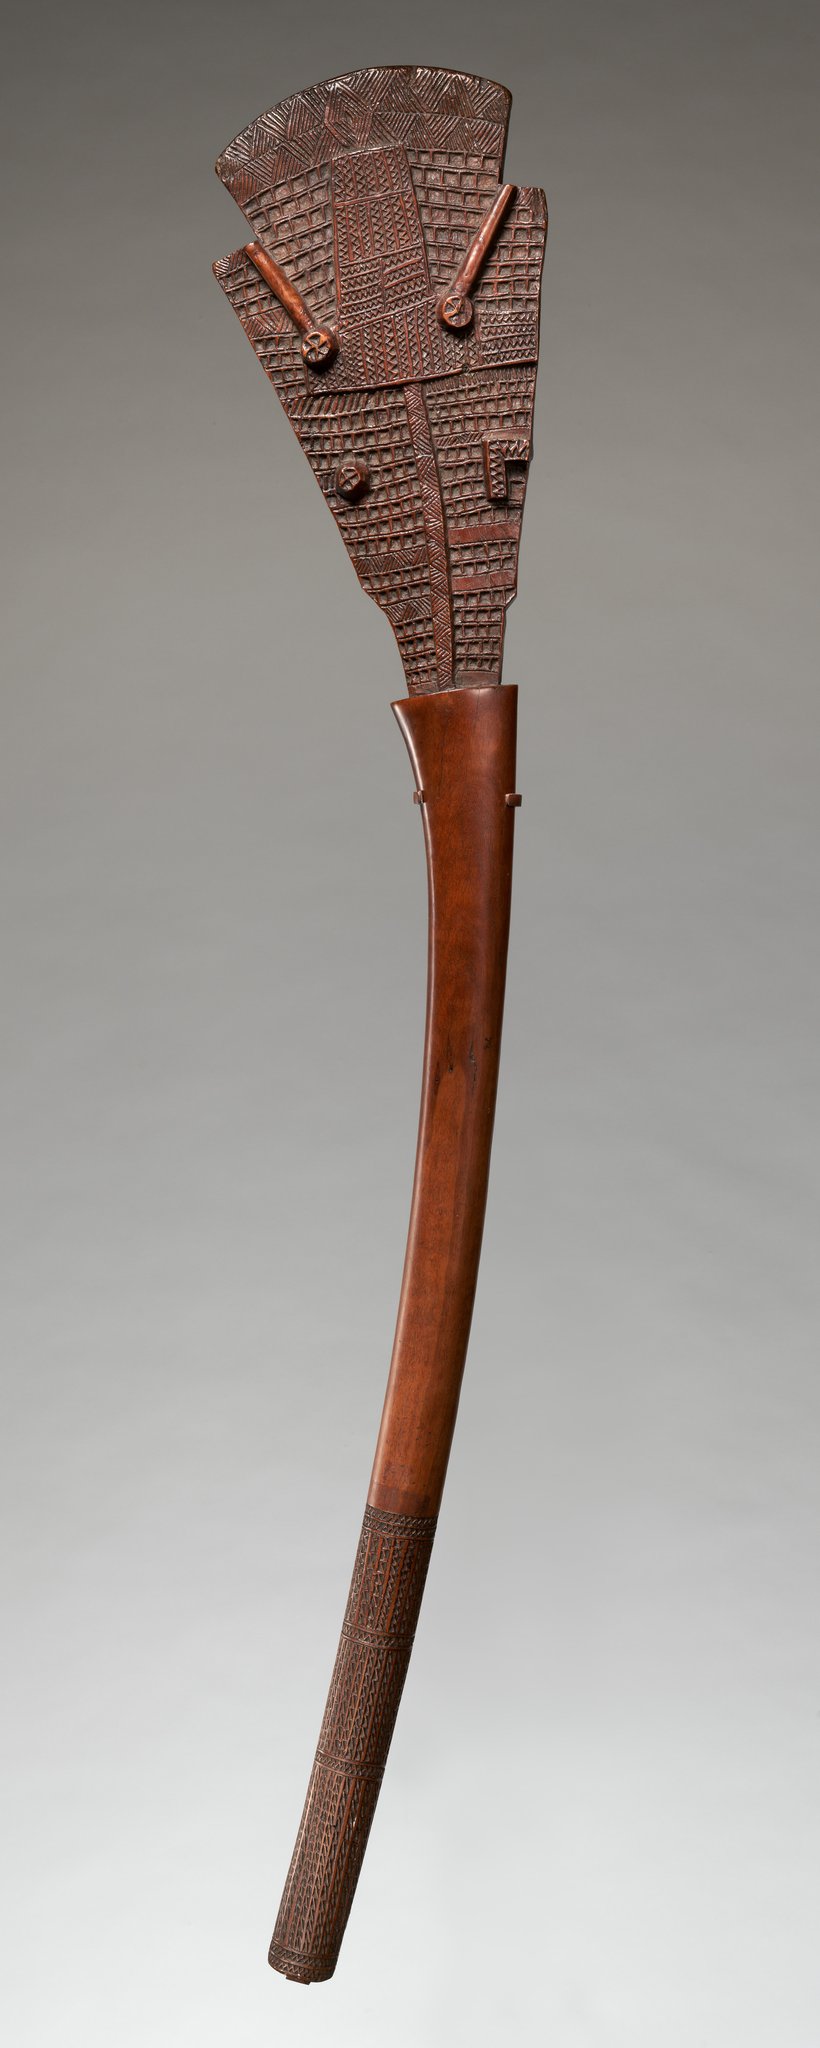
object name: club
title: Club (Gugu)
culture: fijian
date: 1801-1900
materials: wood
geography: fiji